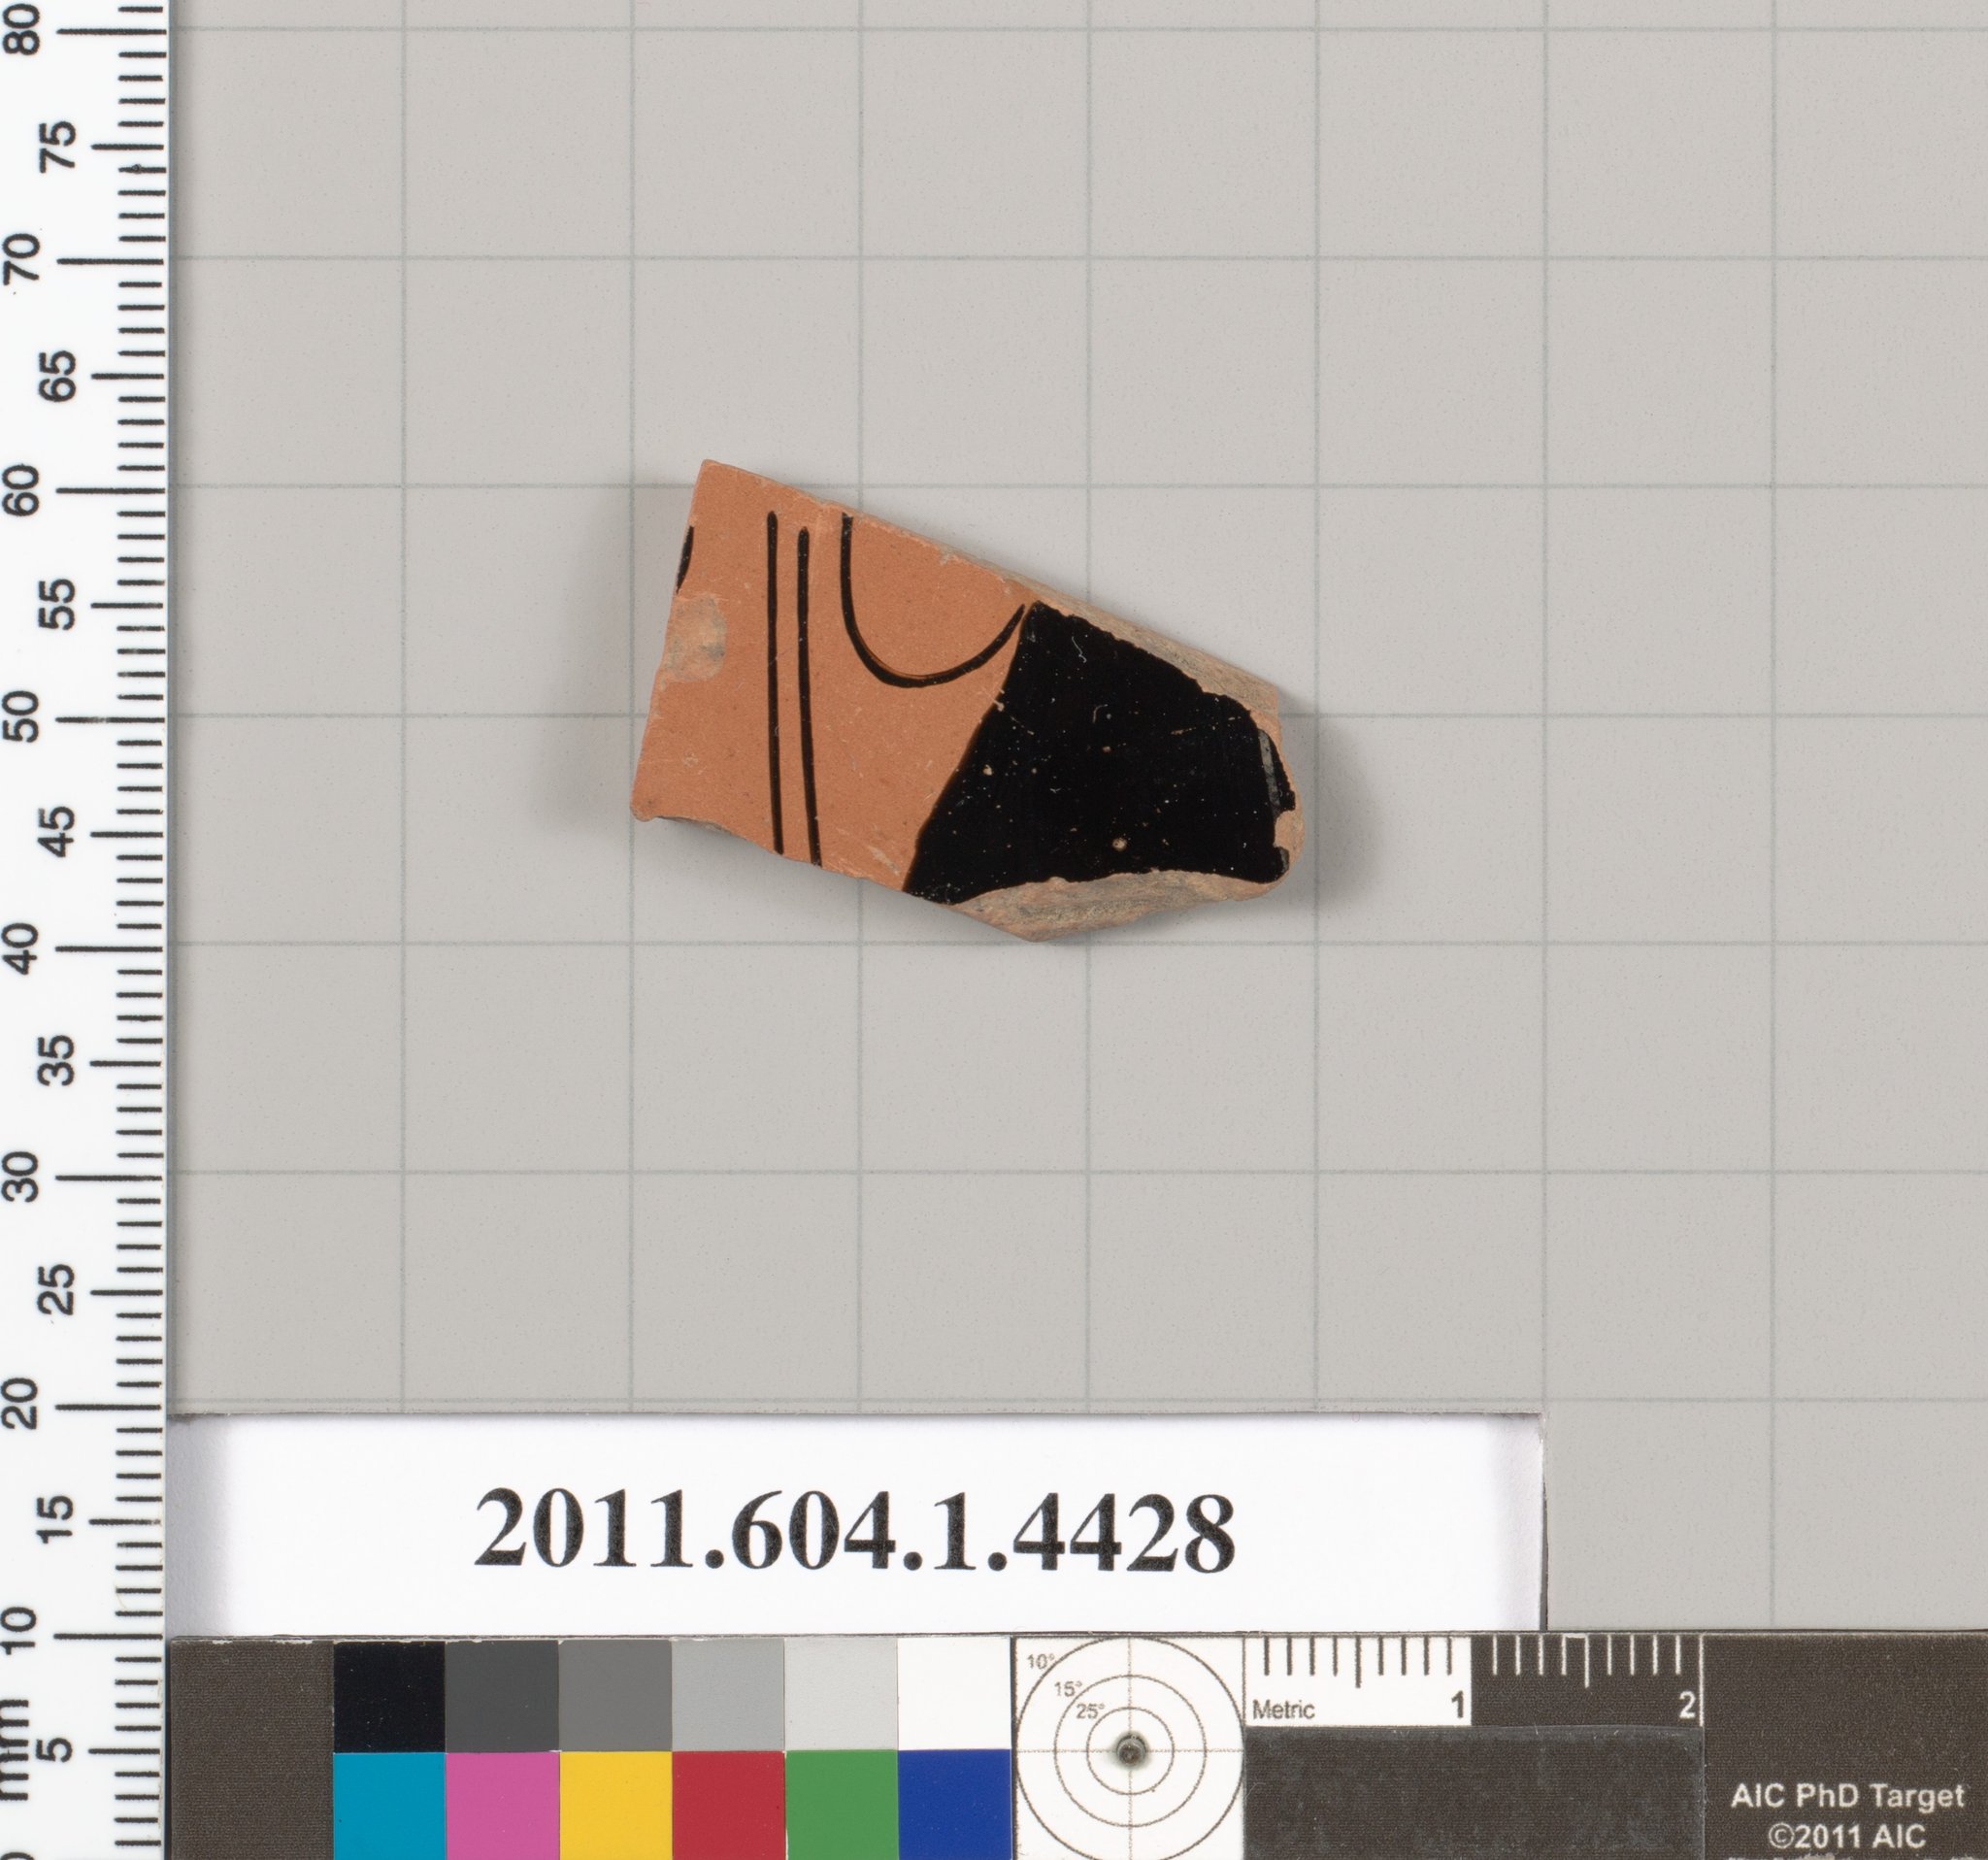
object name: kylix fragment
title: Terracotta fragment of a kylix (drinking cup)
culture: greek, attic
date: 490-470 BCE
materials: terracotta